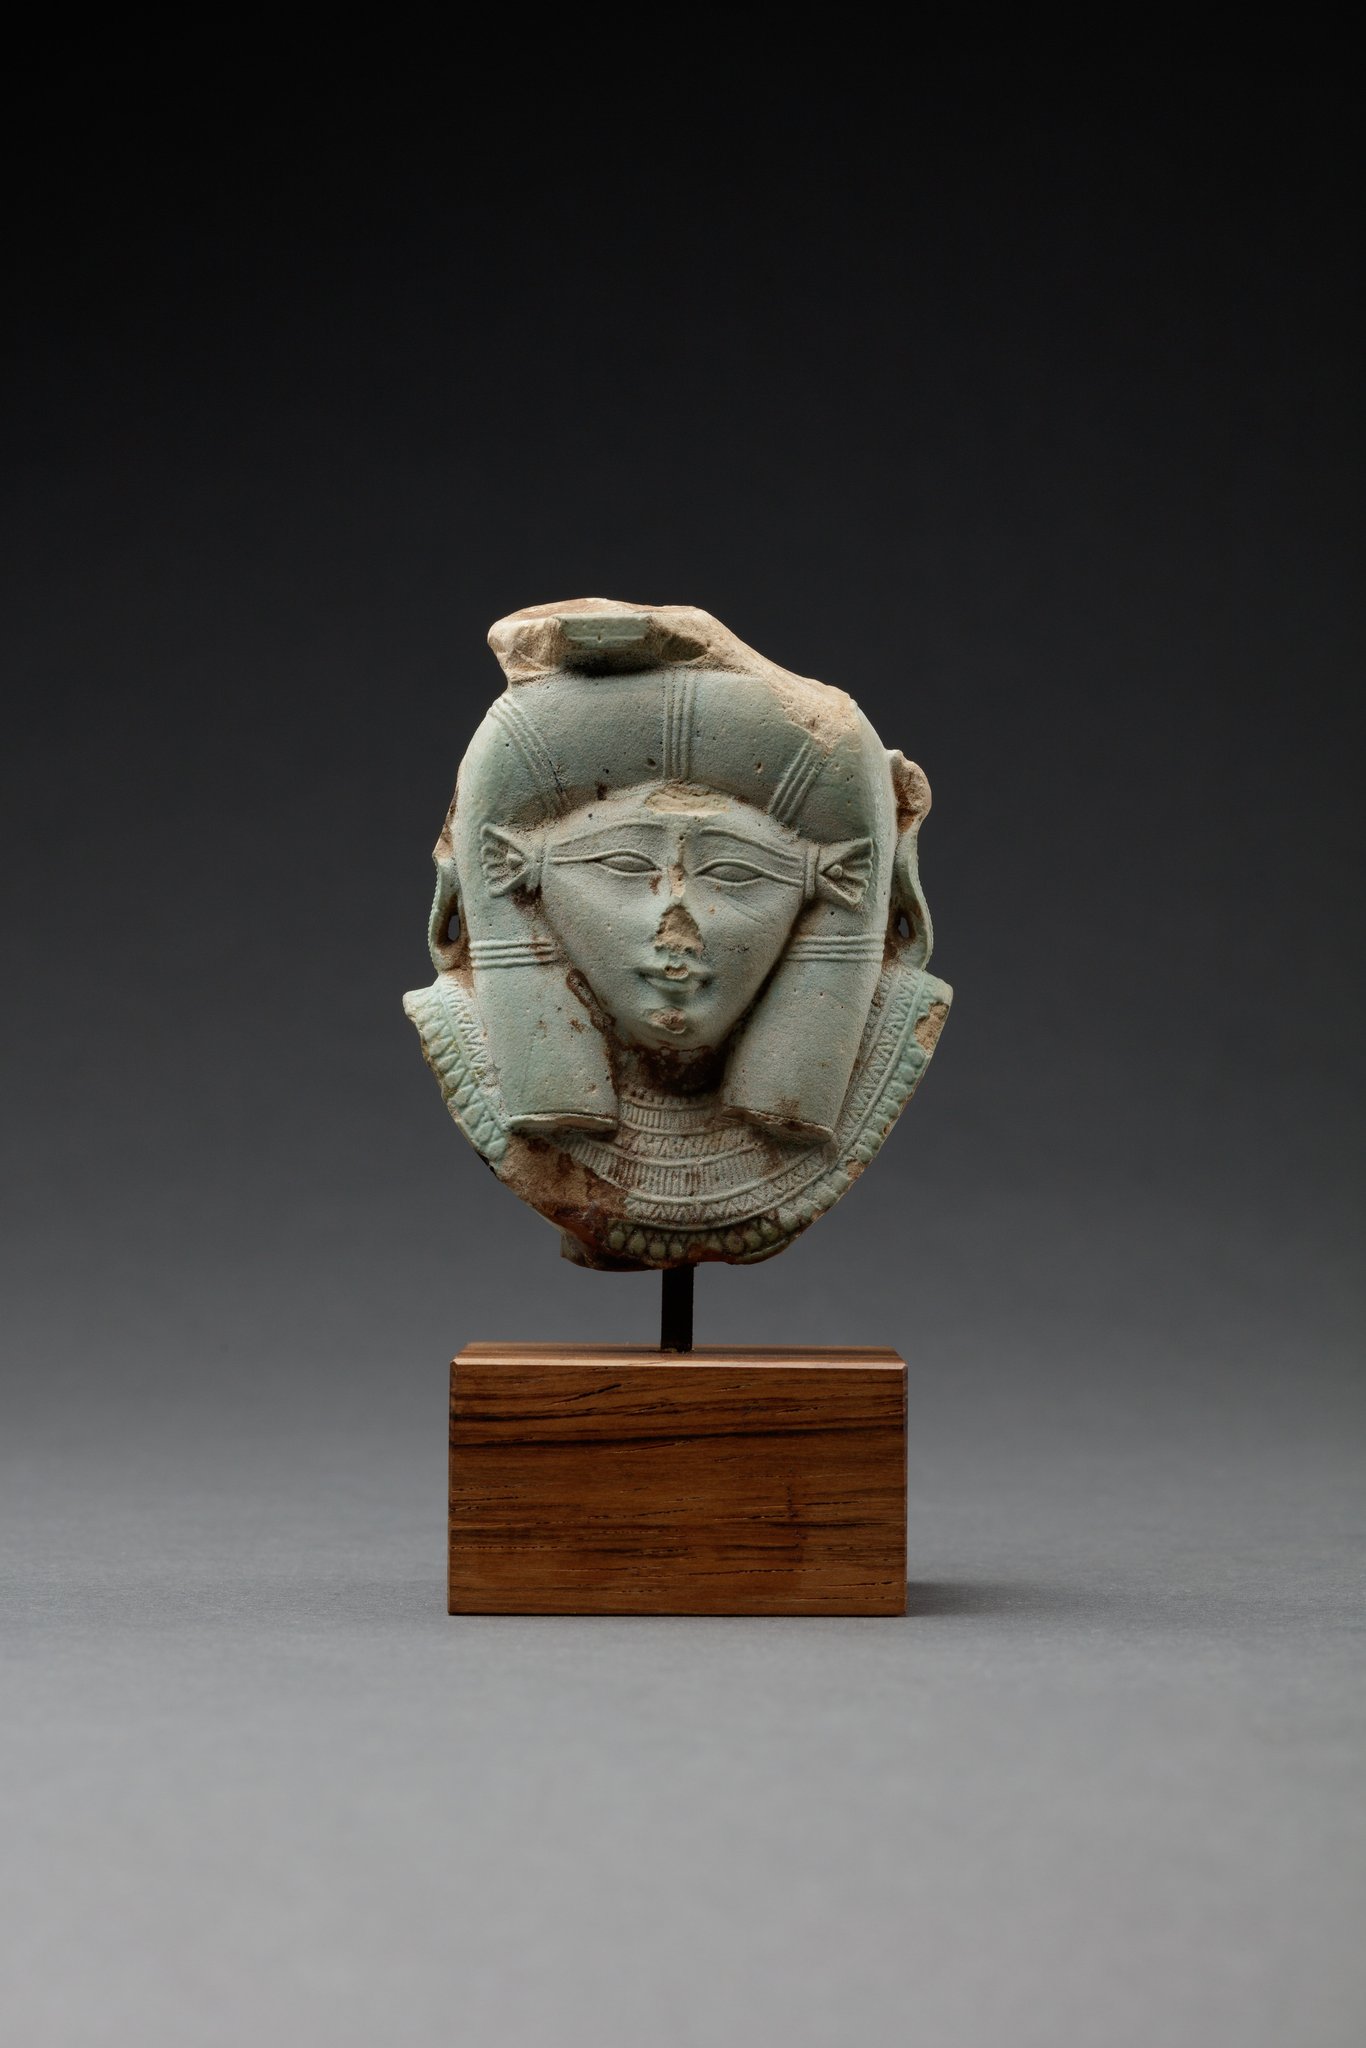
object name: hathor emblem from a sistrum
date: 664-332 BCE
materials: faience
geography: egypt